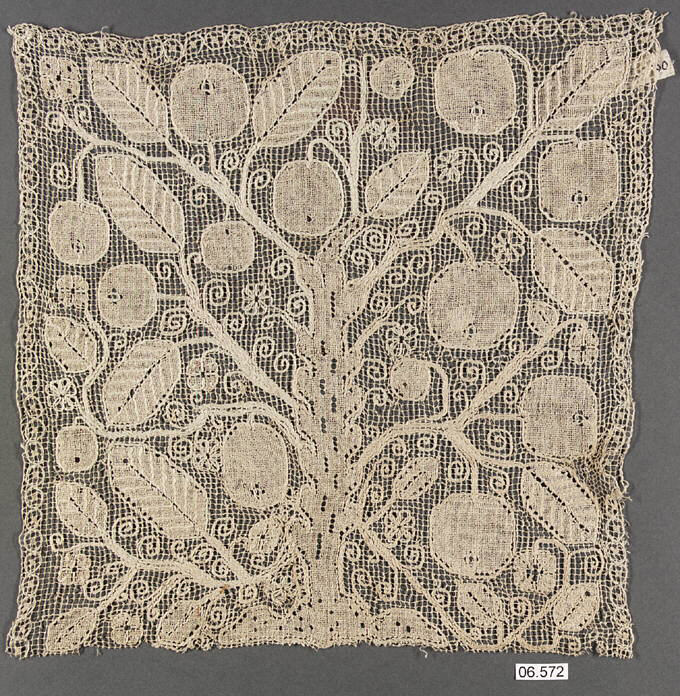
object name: square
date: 1501-1700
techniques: embroidery